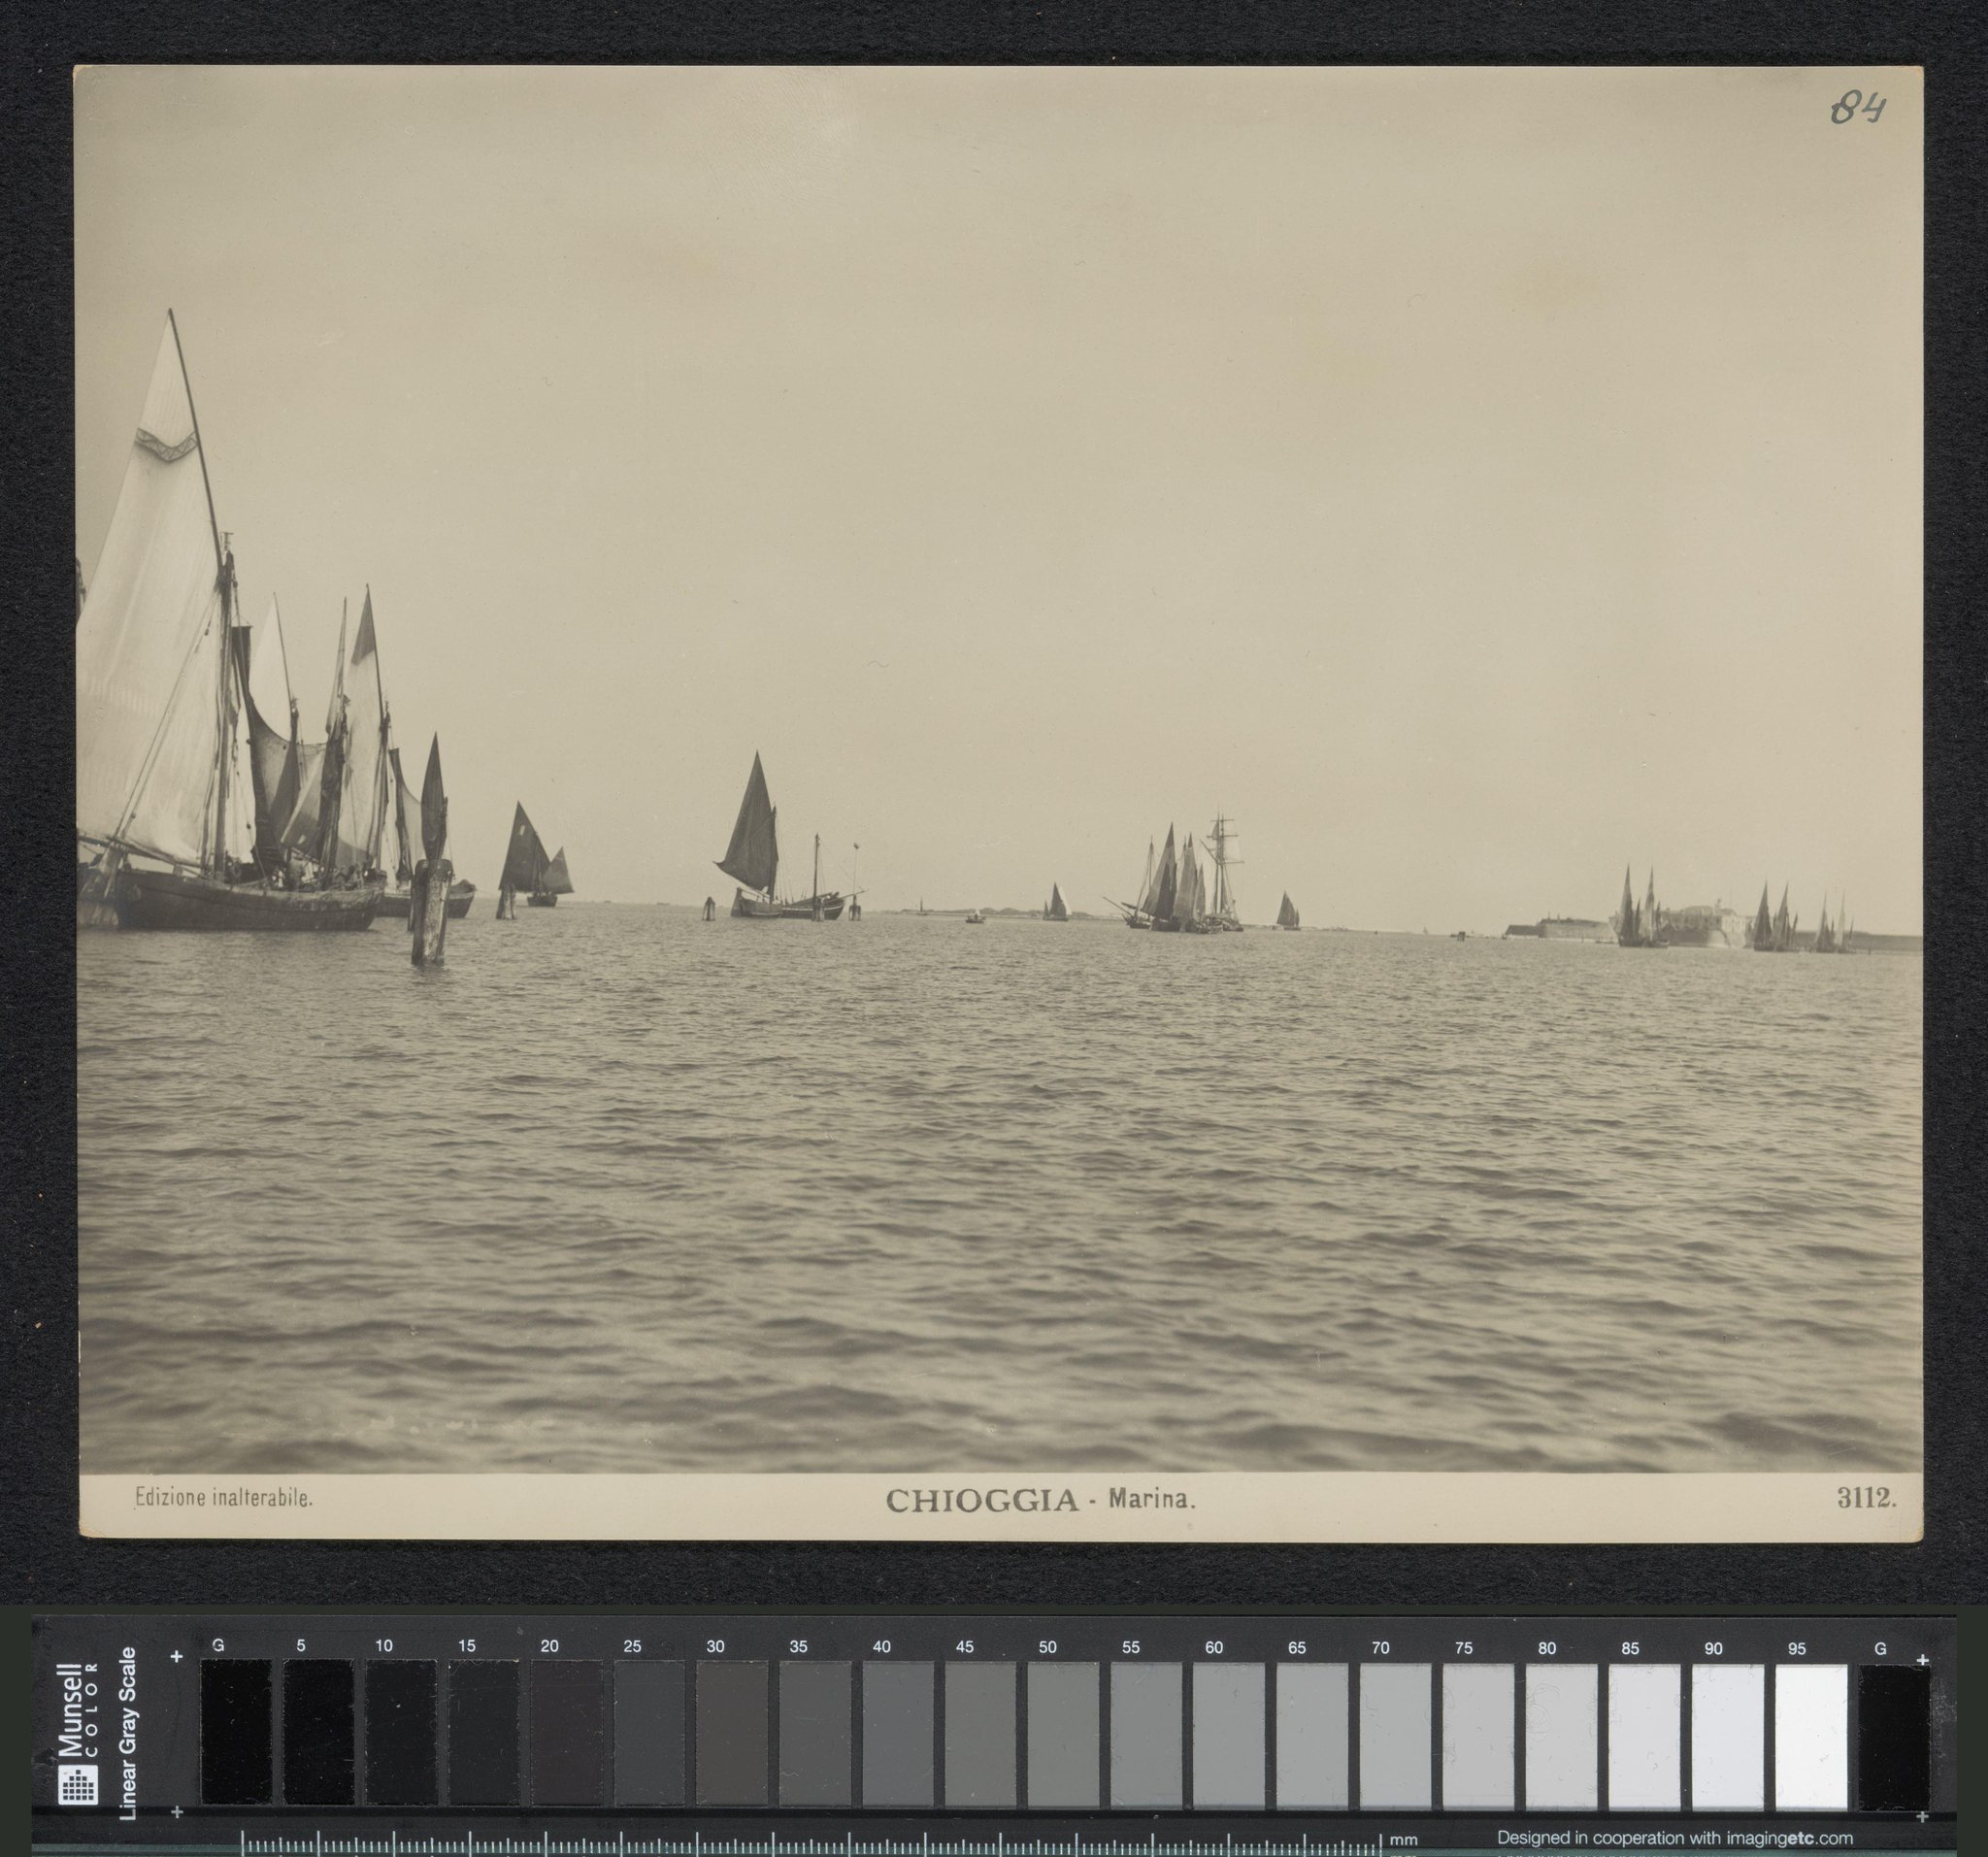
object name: photograph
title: Chioggia - Marina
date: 1900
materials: cardboard, photographic support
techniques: gelatin silver print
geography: adriatic sea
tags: sailing-ship, sailing-boat, sea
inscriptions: number: ‘84.’, number: ‘3112.’